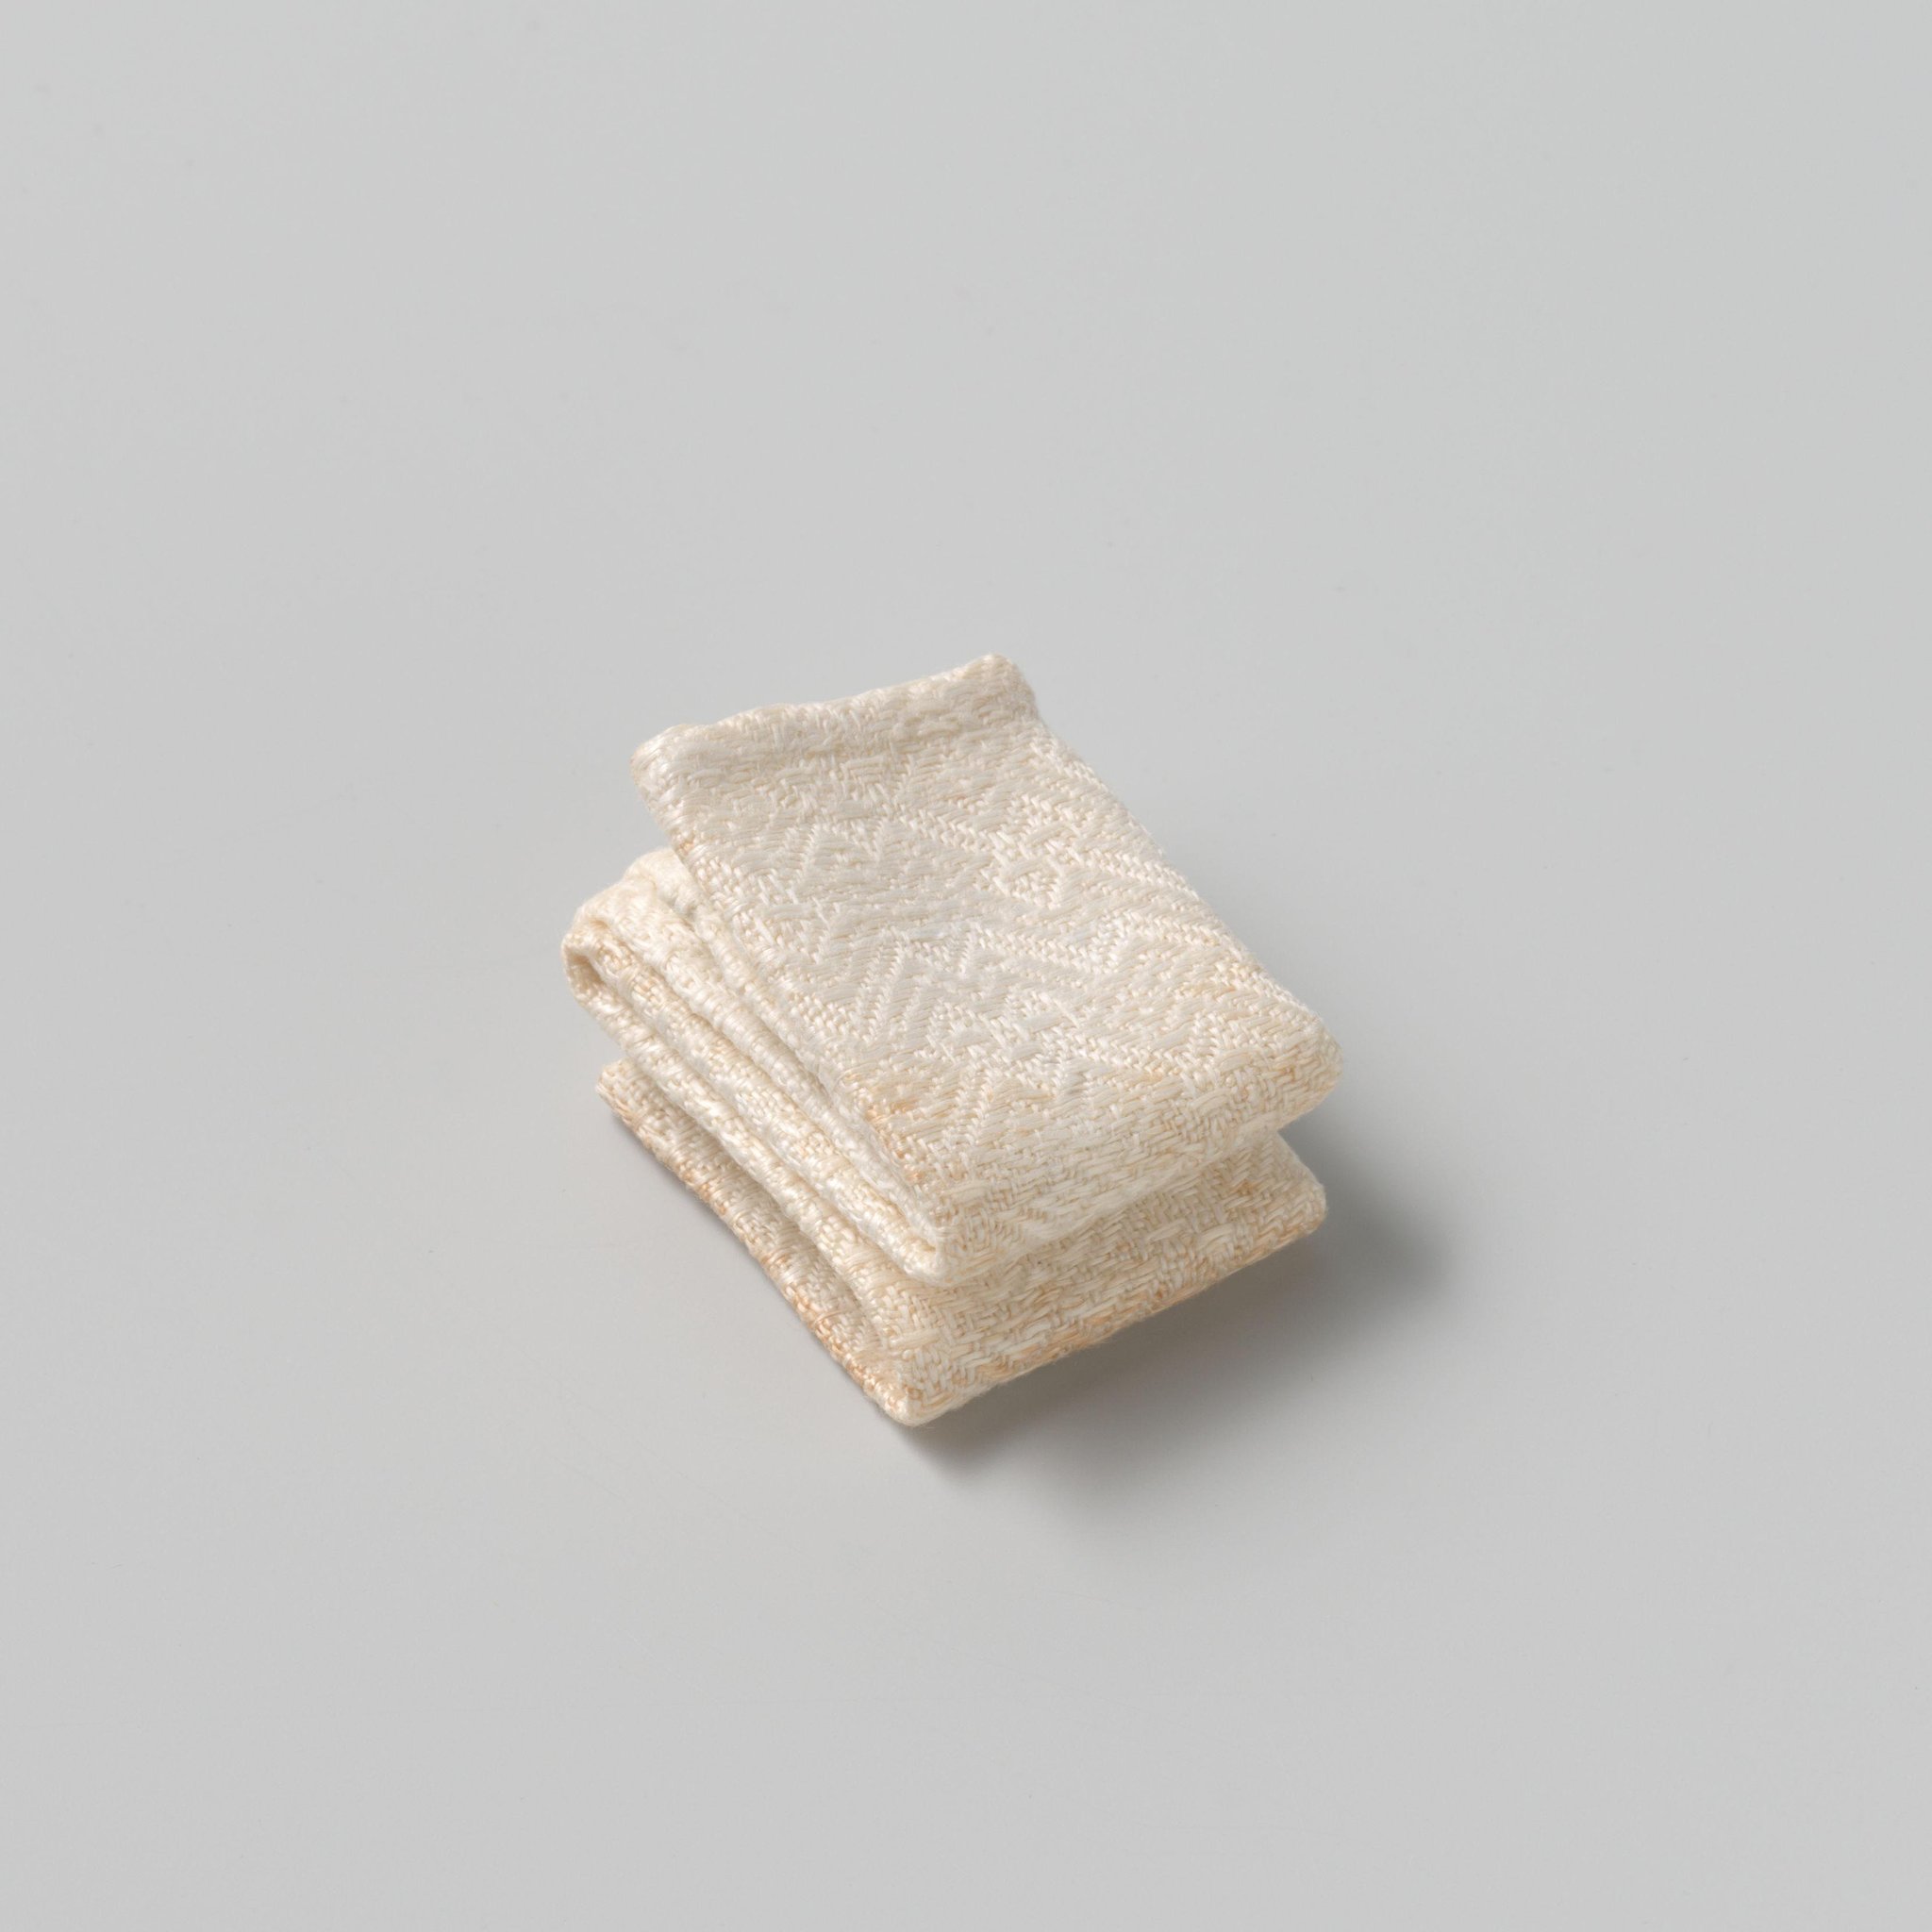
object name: miniature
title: Servet, damastweefsel met pellenpatroon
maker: Anonymous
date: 1600-1699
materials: linen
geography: netherlands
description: Servet, damastweefsel met een pellenpatroon, geknipt uit grotere stukken linnen en aan alle kanten omgezoomd met een fijne zoom.